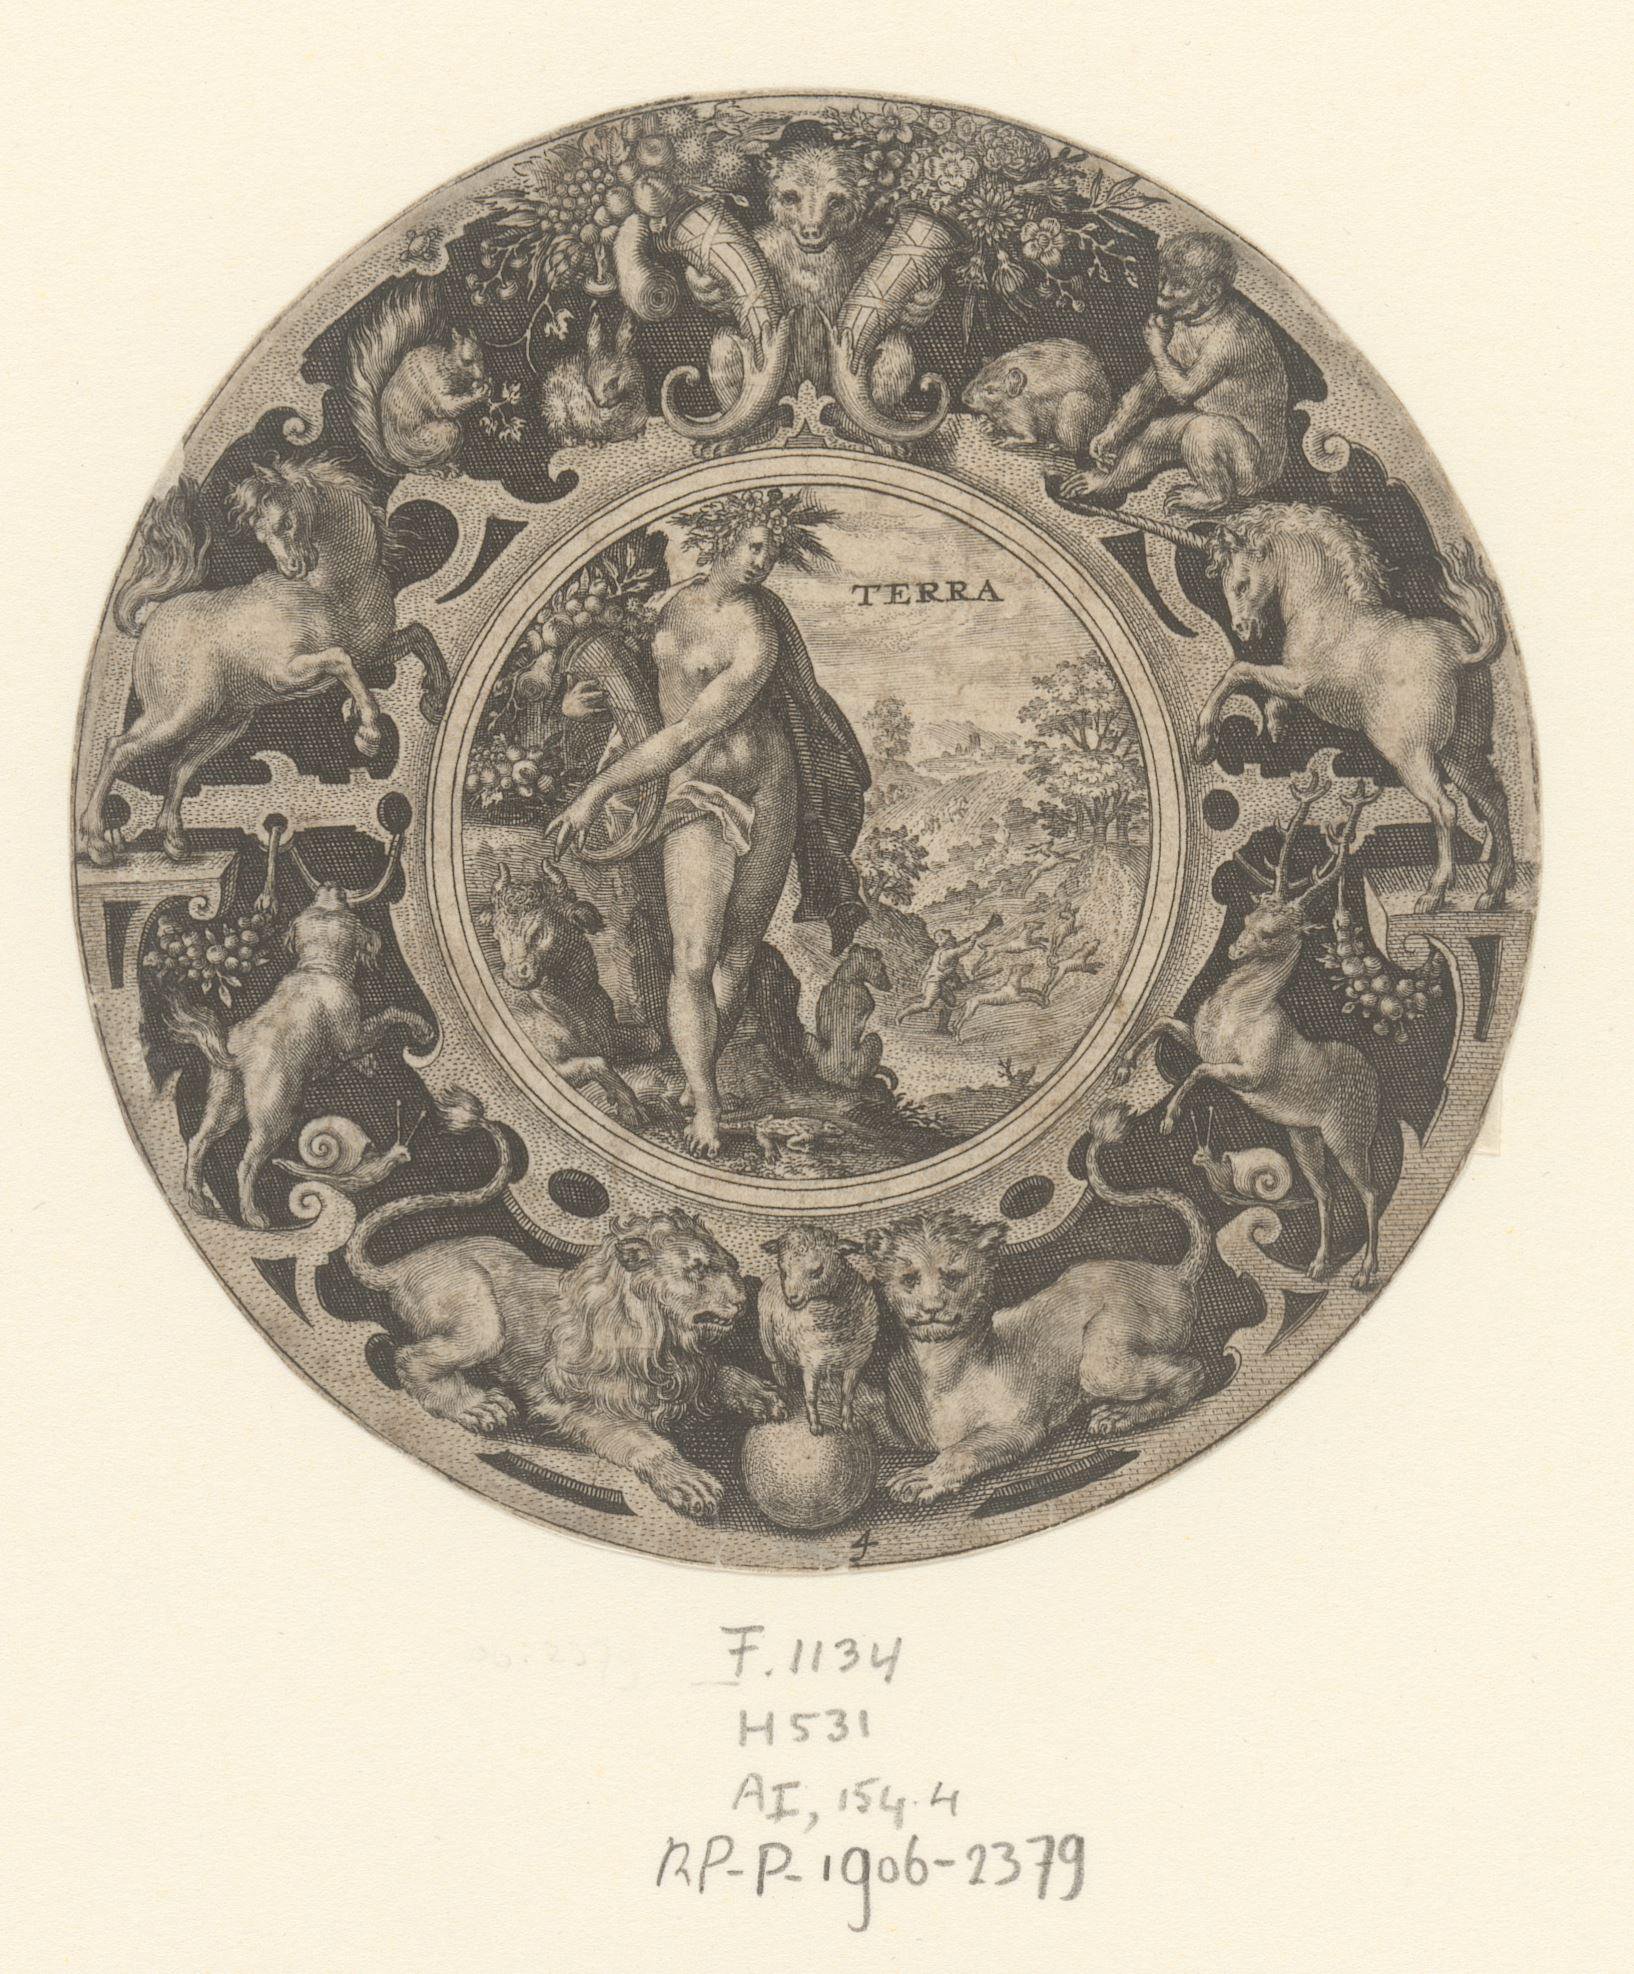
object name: print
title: Terra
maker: crispijn van de passe (i)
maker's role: draughtsman, print maker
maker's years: 1564-1637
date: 1574-1637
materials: paper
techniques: engraving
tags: 'cornucopia', horn of plenty, game, hunted animals, 'terra', 'carro della terra' (ripa)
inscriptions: collector's mark: Lugt 2228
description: Landschap met de vrouwelijke personificatie van het element aarde, met een hoorn des overvloeds. Op de achtergrond een hertenjacht. De prent heeft een ornamentele rand die is versierd met dieren die het element symboliseren.